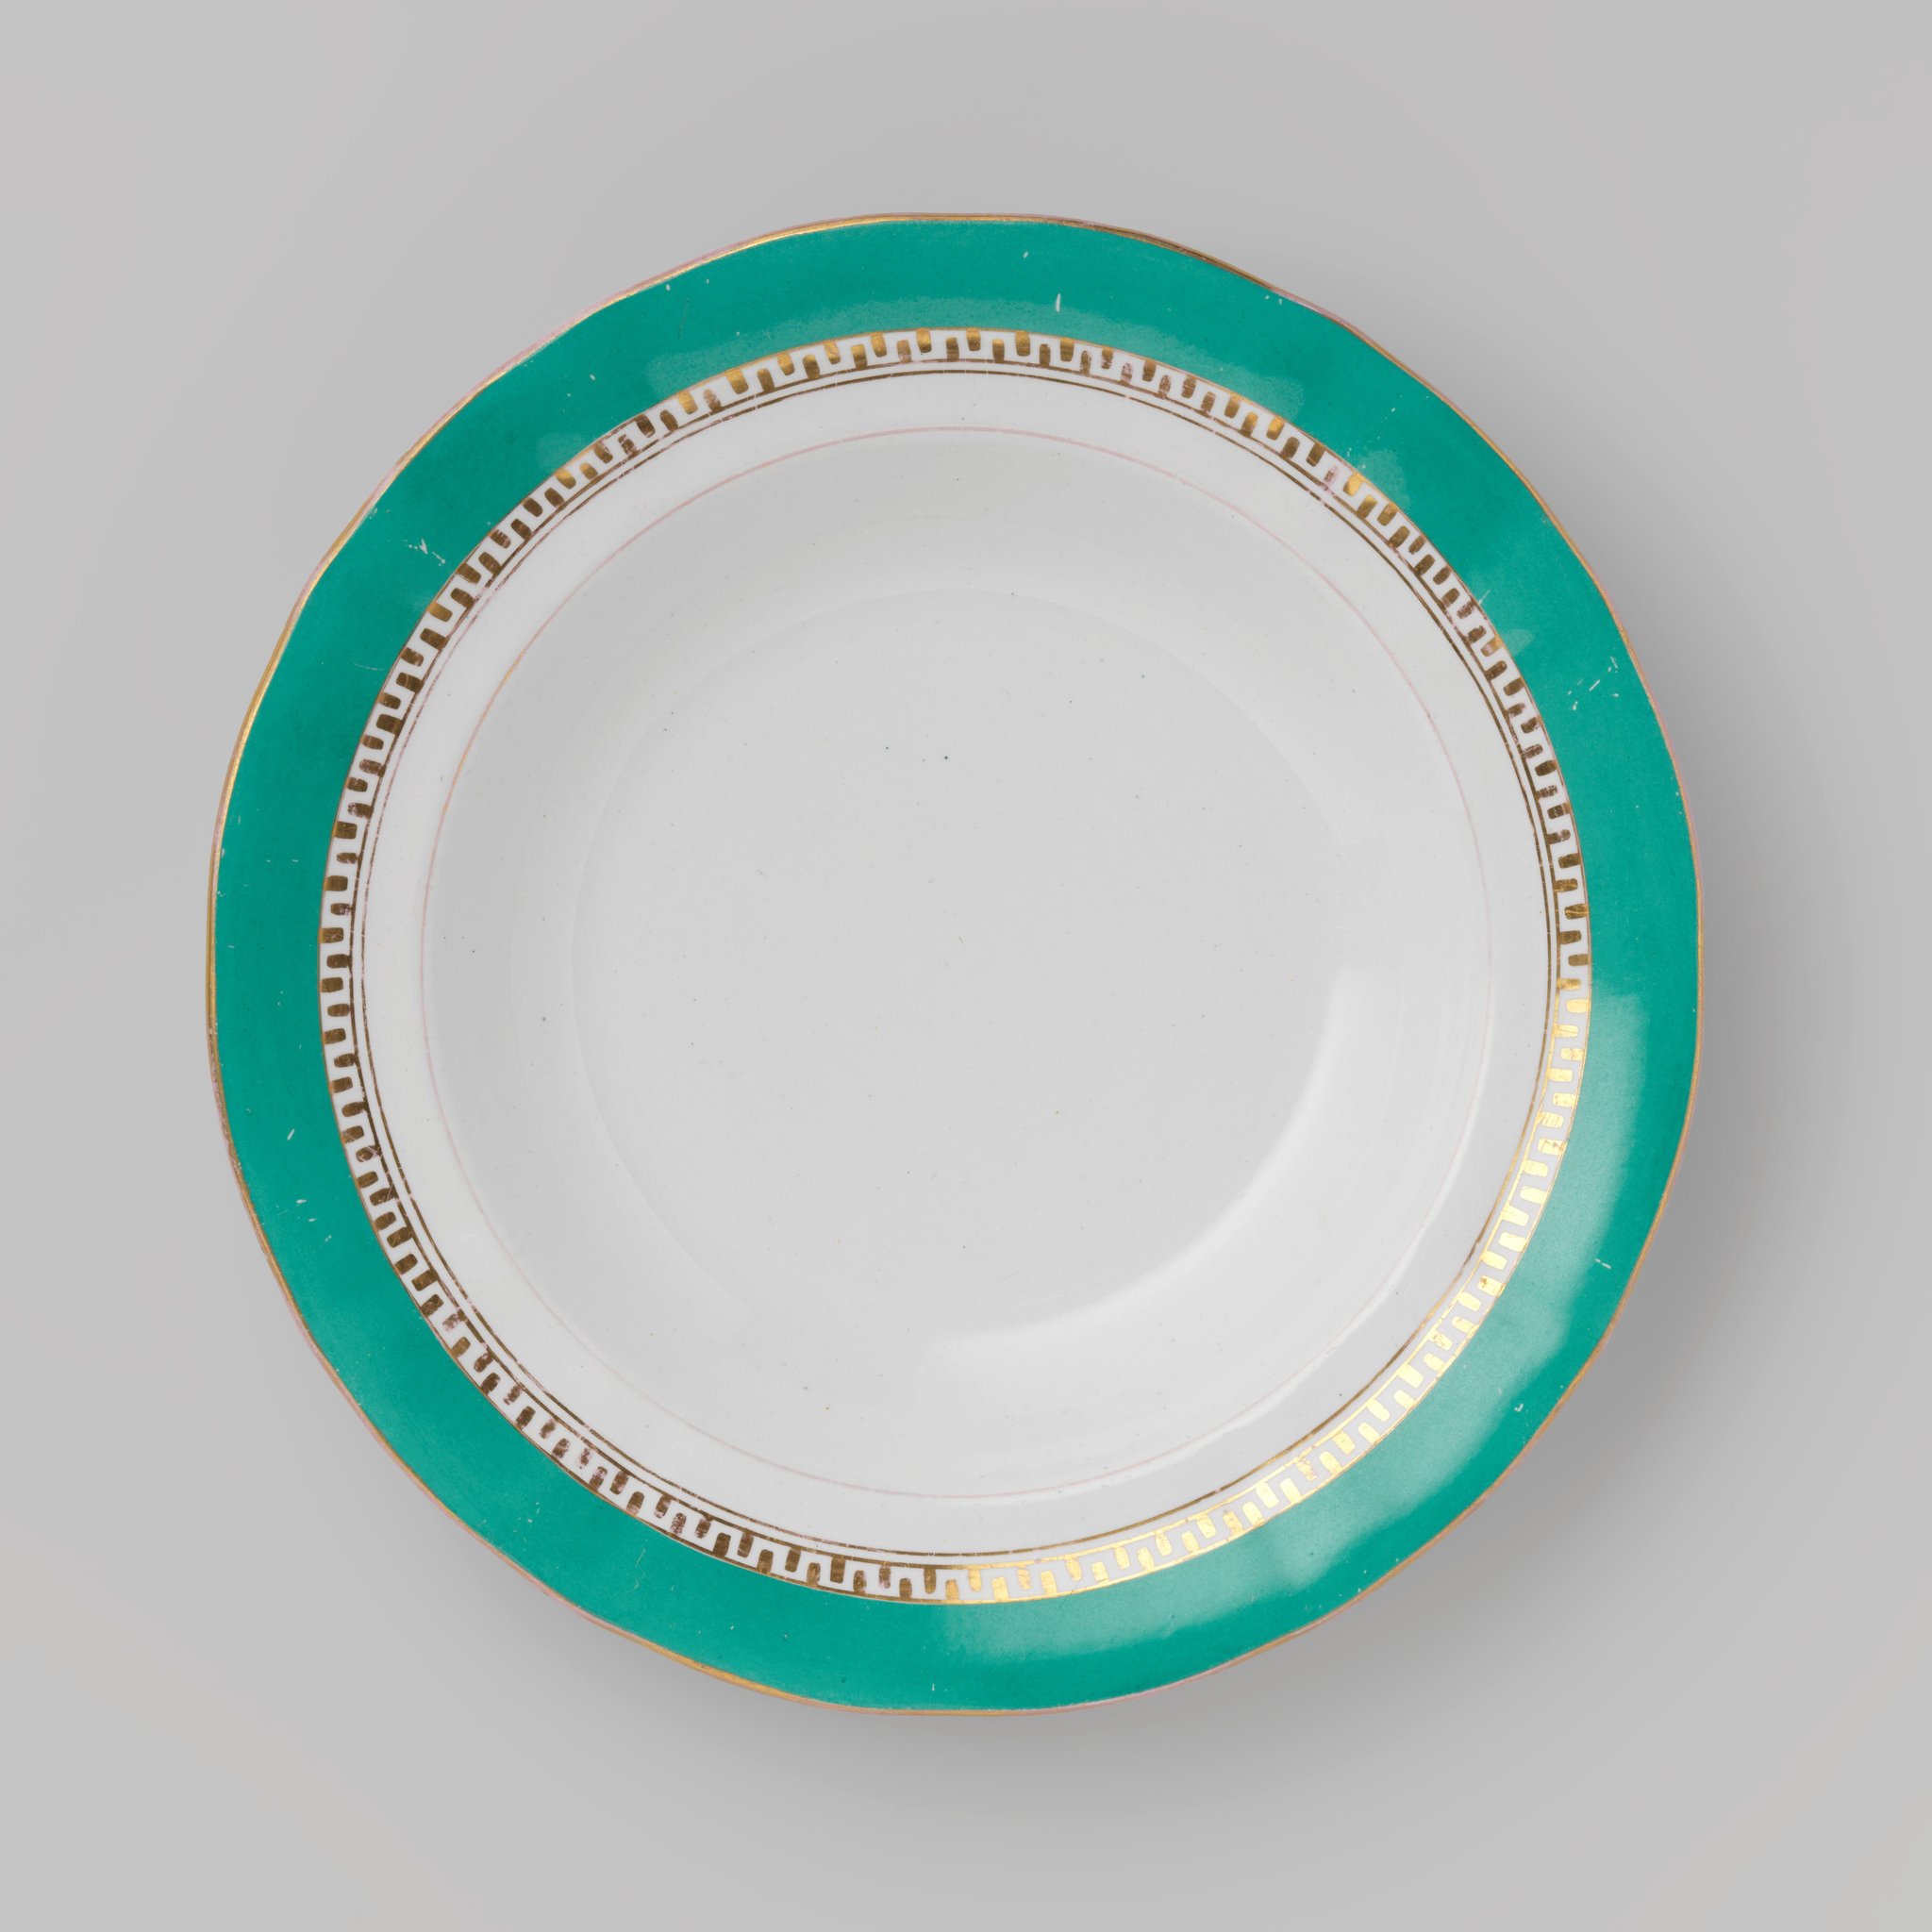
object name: plate dish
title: Bord, met groene rand en gouden Griekse band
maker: petrus regout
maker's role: plateelbakker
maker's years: 1801-1879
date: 1865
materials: earthenware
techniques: transfer decoration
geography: maastricht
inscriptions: check stamp: ‘P. REGOUT // MAASTRICHT // 8X’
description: Bord van aardewerk, geschulpt, met groene rand en gouden Griekse band.